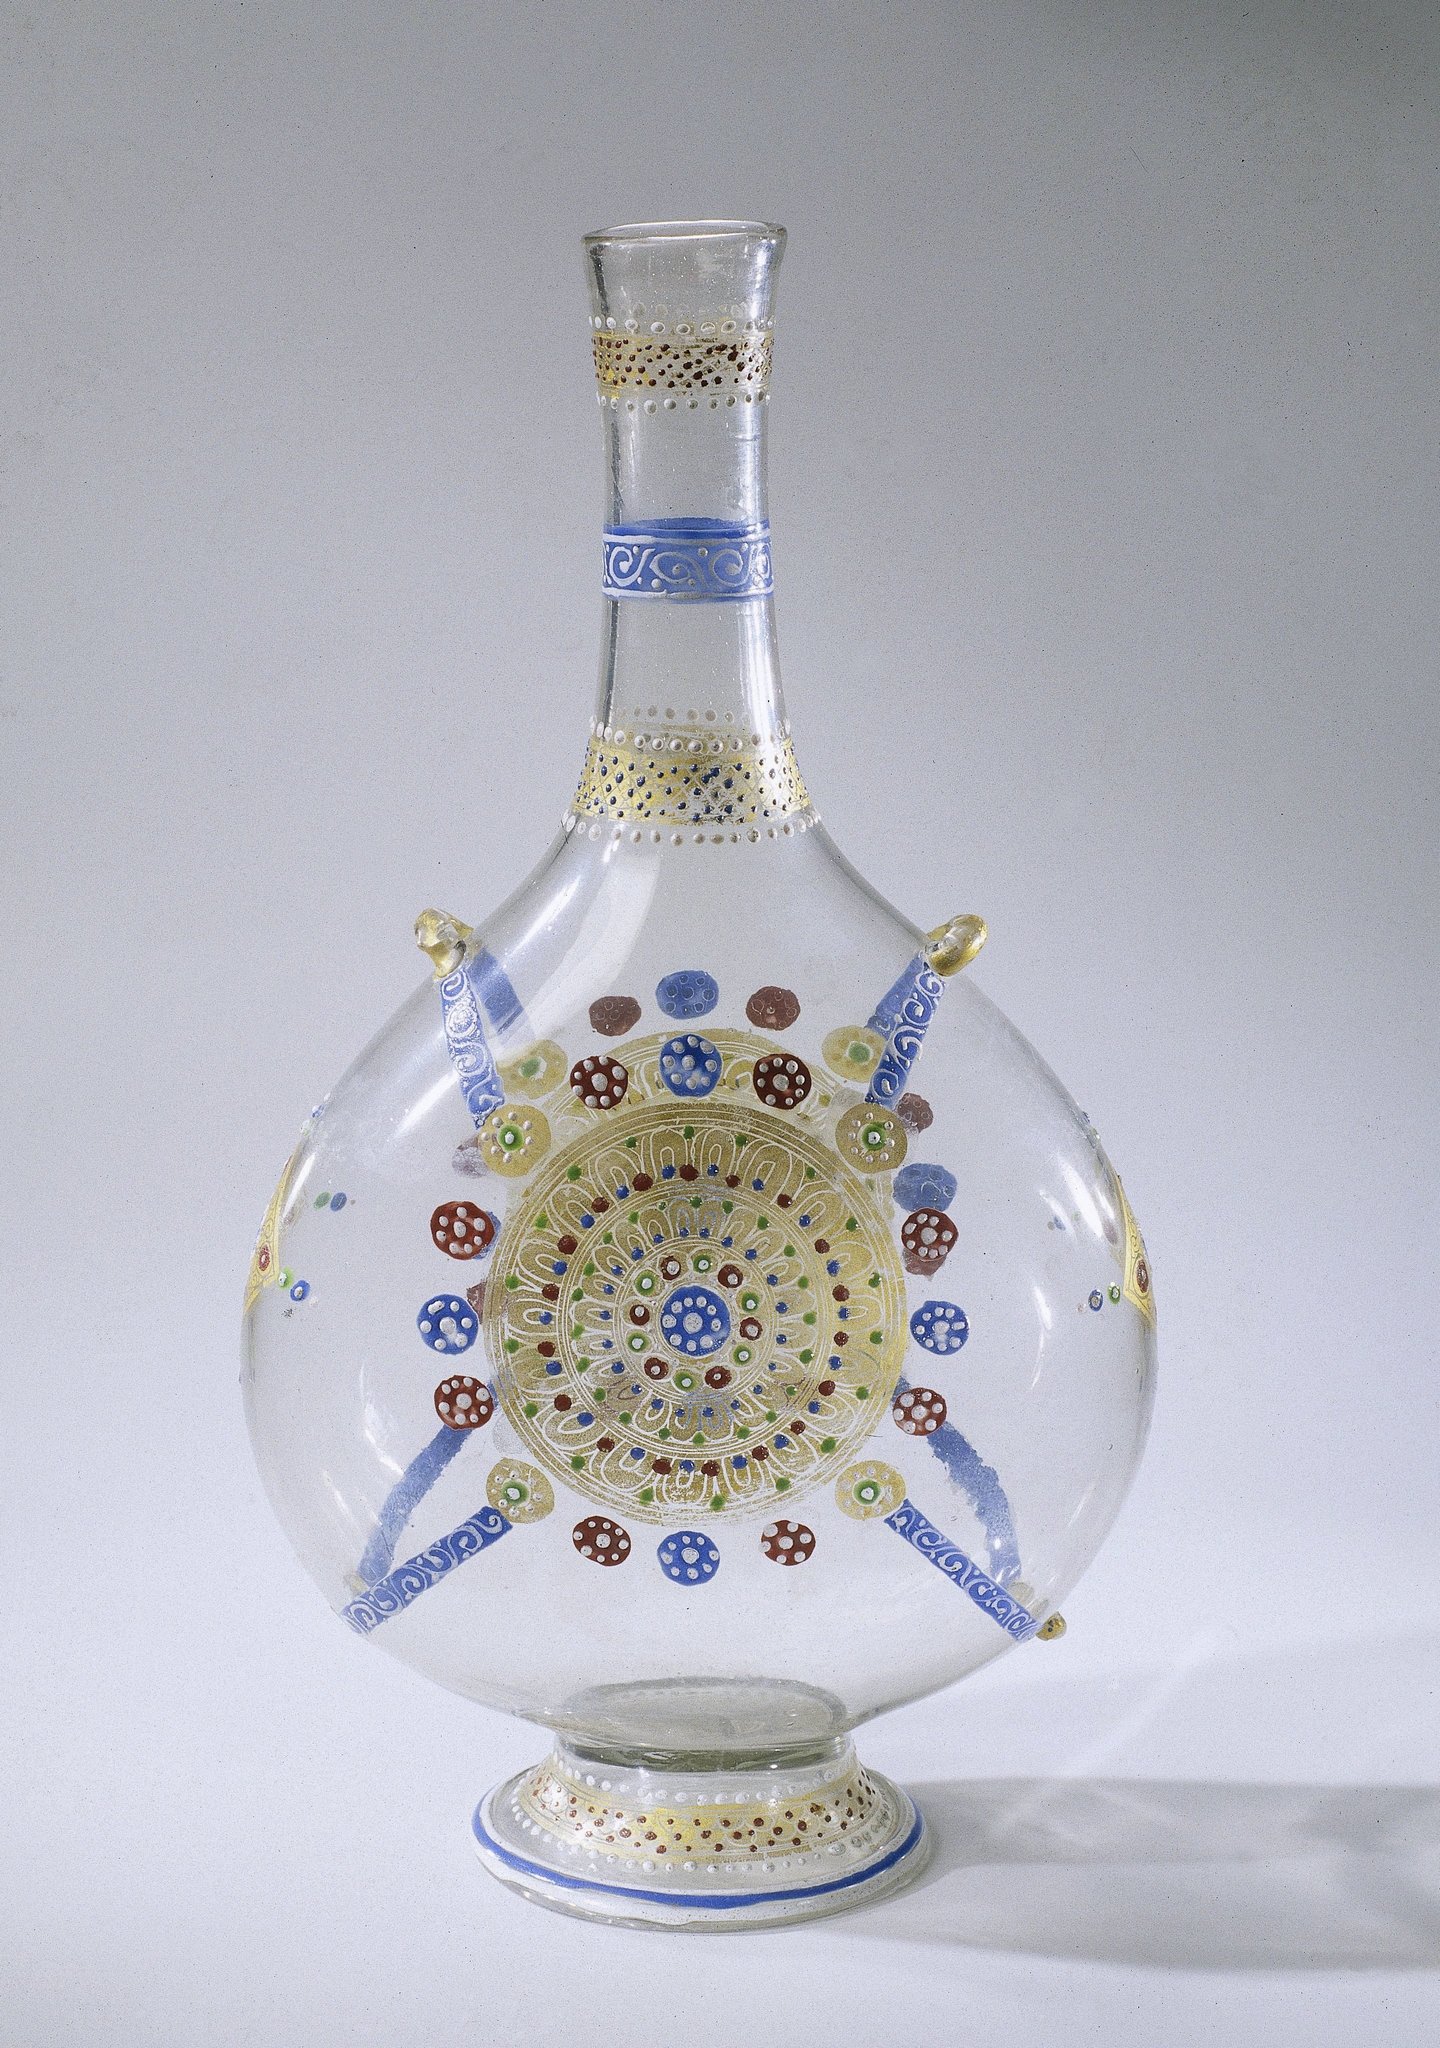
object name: pilgrim bottle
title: Pelgrimsfles, veelkleurig beschilderd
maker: Anonymous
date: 1500-1525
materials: glass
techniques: gilding, glassblowing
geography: venice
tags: rosette ~ ornament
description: Pelgrimsfles, lage concave voet met omgeslagen rand. Afgeplat bolvormig lichaam overgaande in een slanke hals, aan de bovenzijde licht uitgebogen. Aan de zijkanten onderaan en op de schouders een oog. Op de voor- en achterzijde een in verguldsel gegraveerde rozet, verlevendigd met kleine rozetten in blauw, rood en groen met witte stippen. Op de zijkant een vergulde en gegraveerde ruit met gekleurde stippen. Op de voet een vergulde en gegraveerde band met gekleurde stippen. Om het midden van de hals een gekleurde band met witte arabesken tussen twee vergulde en gegraveerde banden met gekleurde stippen. Gekleurde banden met witte arabesken verbinden de centrale rozet met de vier ogen.